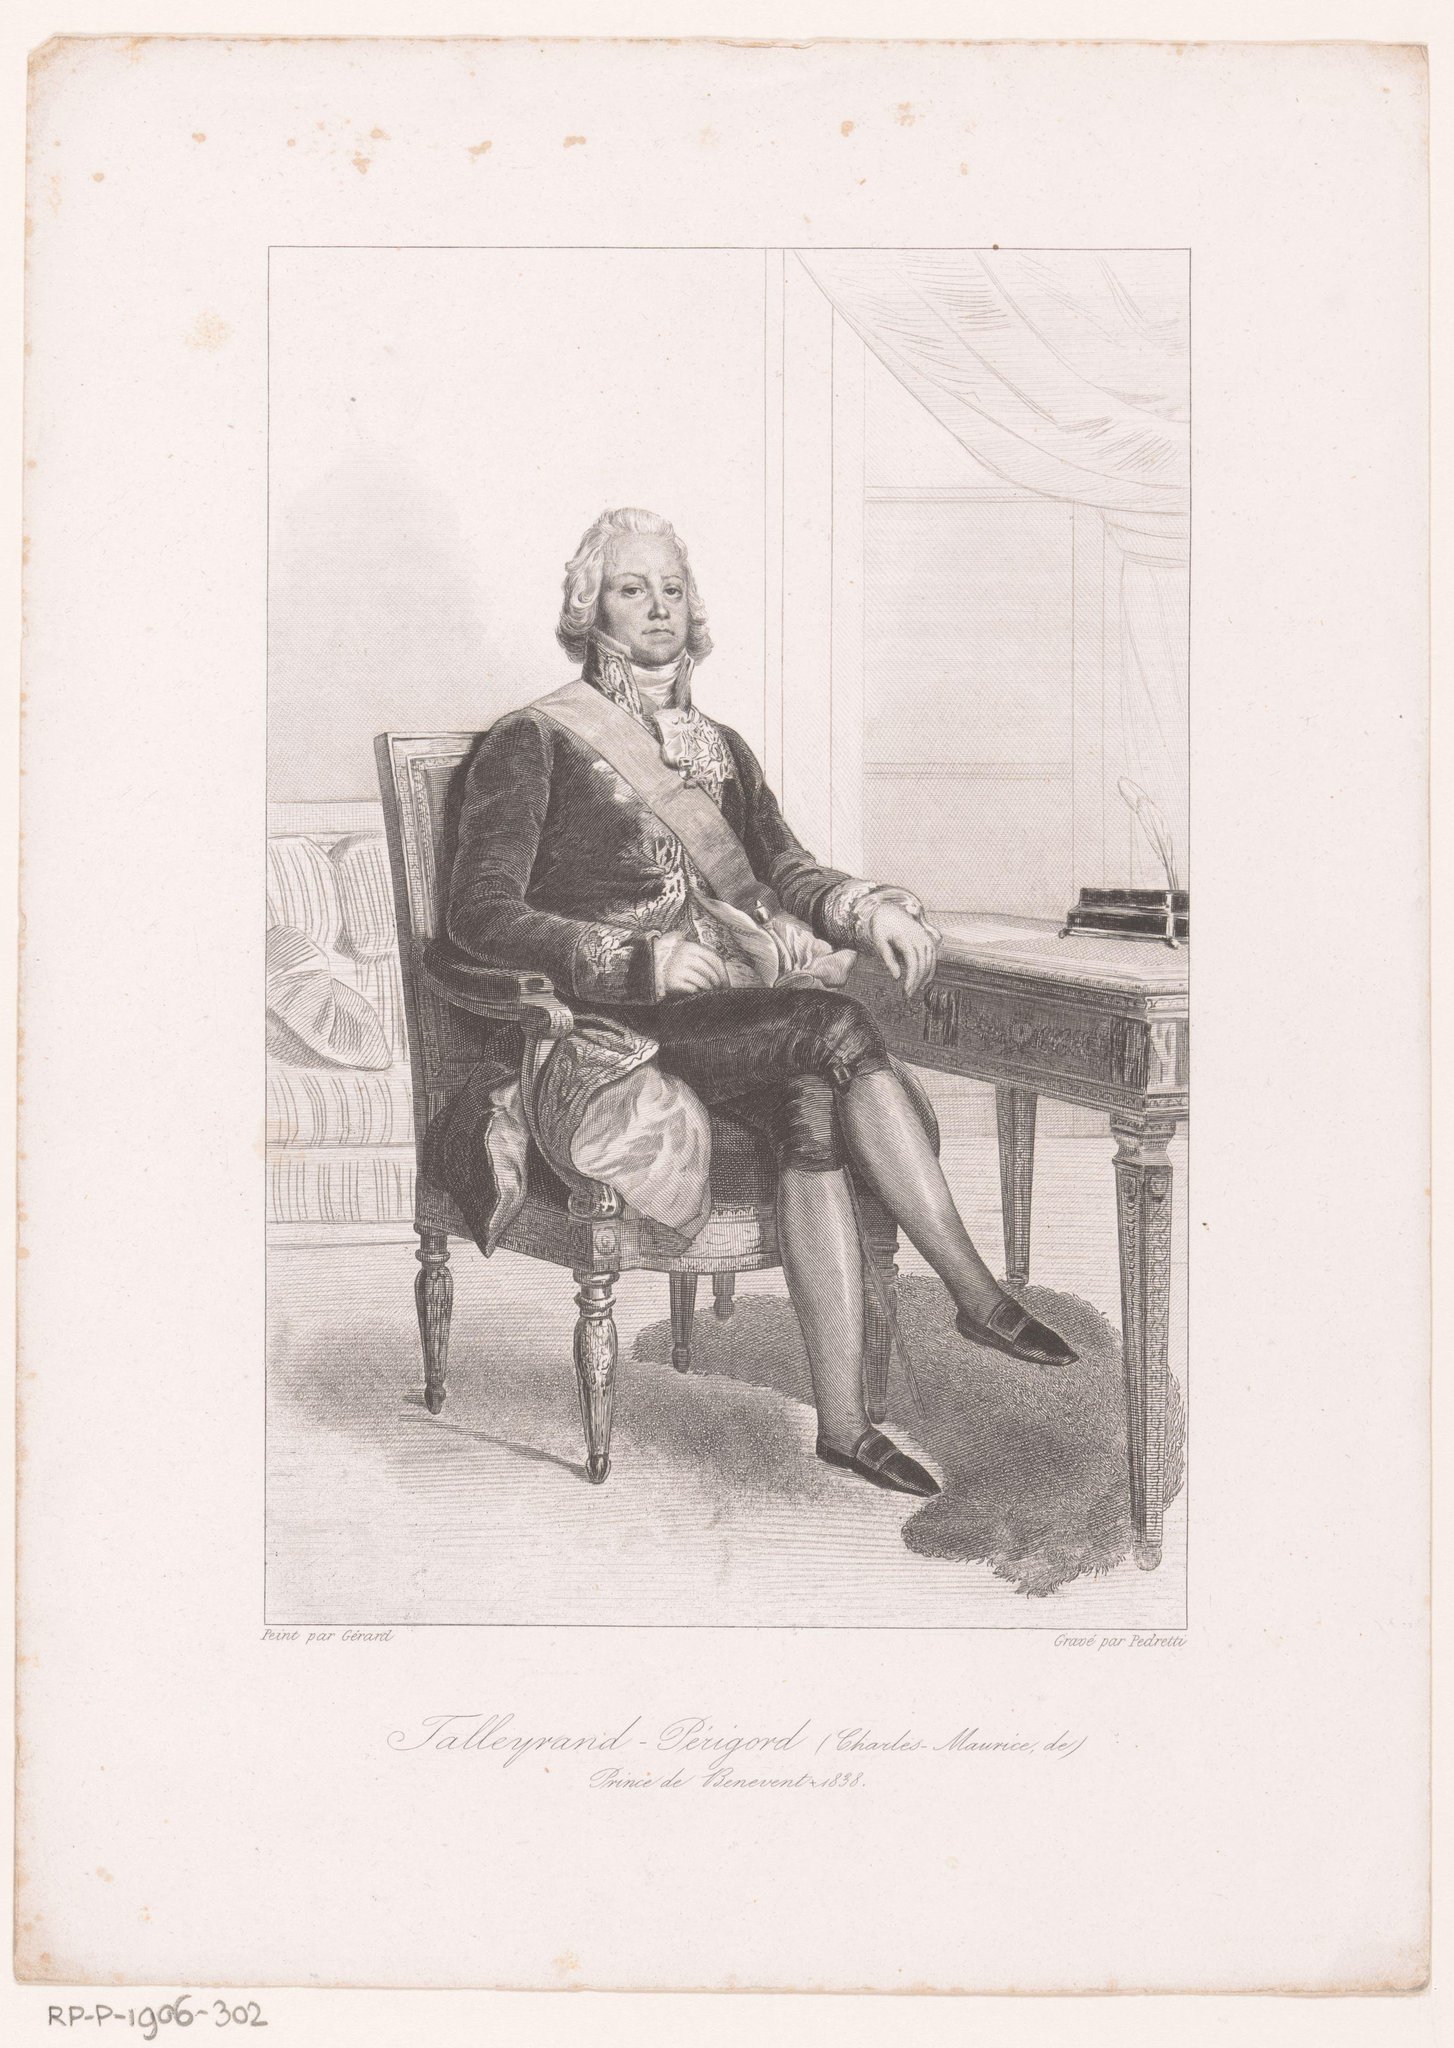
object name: print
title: Talleyrand-Périgord Charles-Maurice de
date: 1831-1841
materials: paper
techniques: engraving, etching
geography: paris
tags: paris, politician, charles maurice hertog van talleyrand-périgord, historical persons, politician, e.g. party leader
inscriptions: collector's mark: Lugt 2228